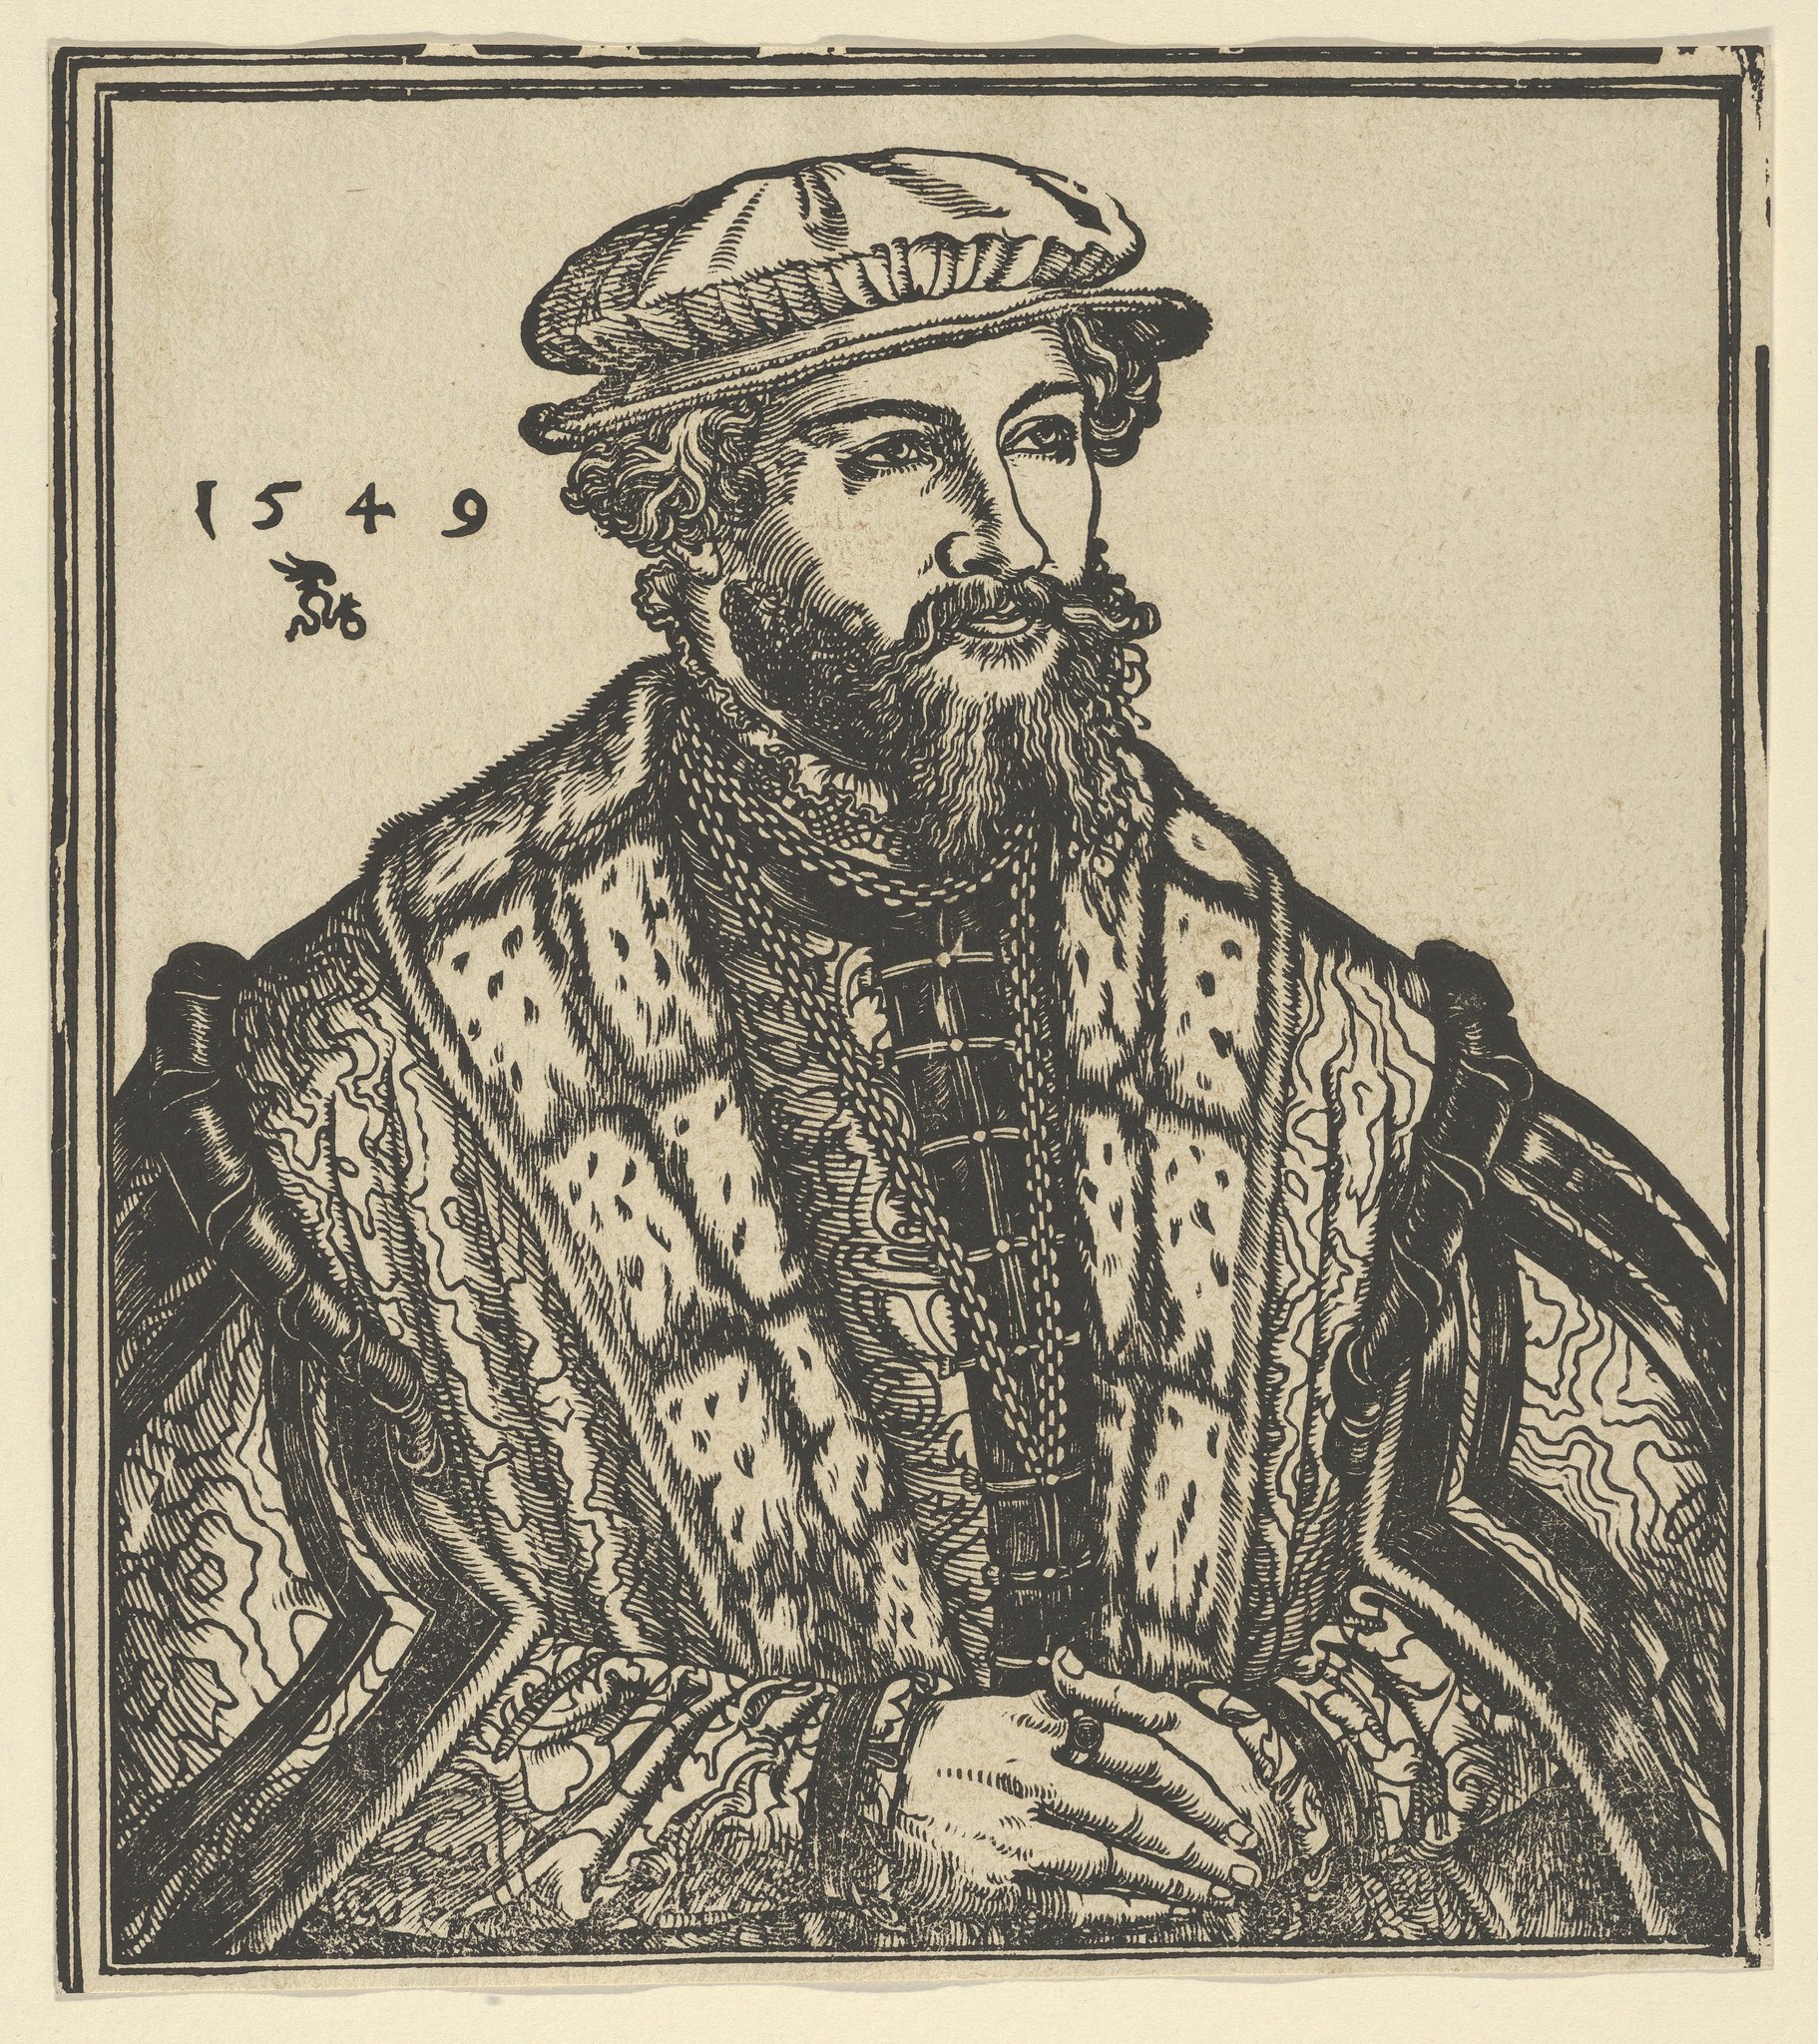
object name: print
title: Dr. Christian Bruck, called Pontanus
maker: lucas cranach the younger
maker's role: artist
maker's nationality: german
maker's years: 1515-1586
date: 1549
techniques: woodcut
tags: men,portraits